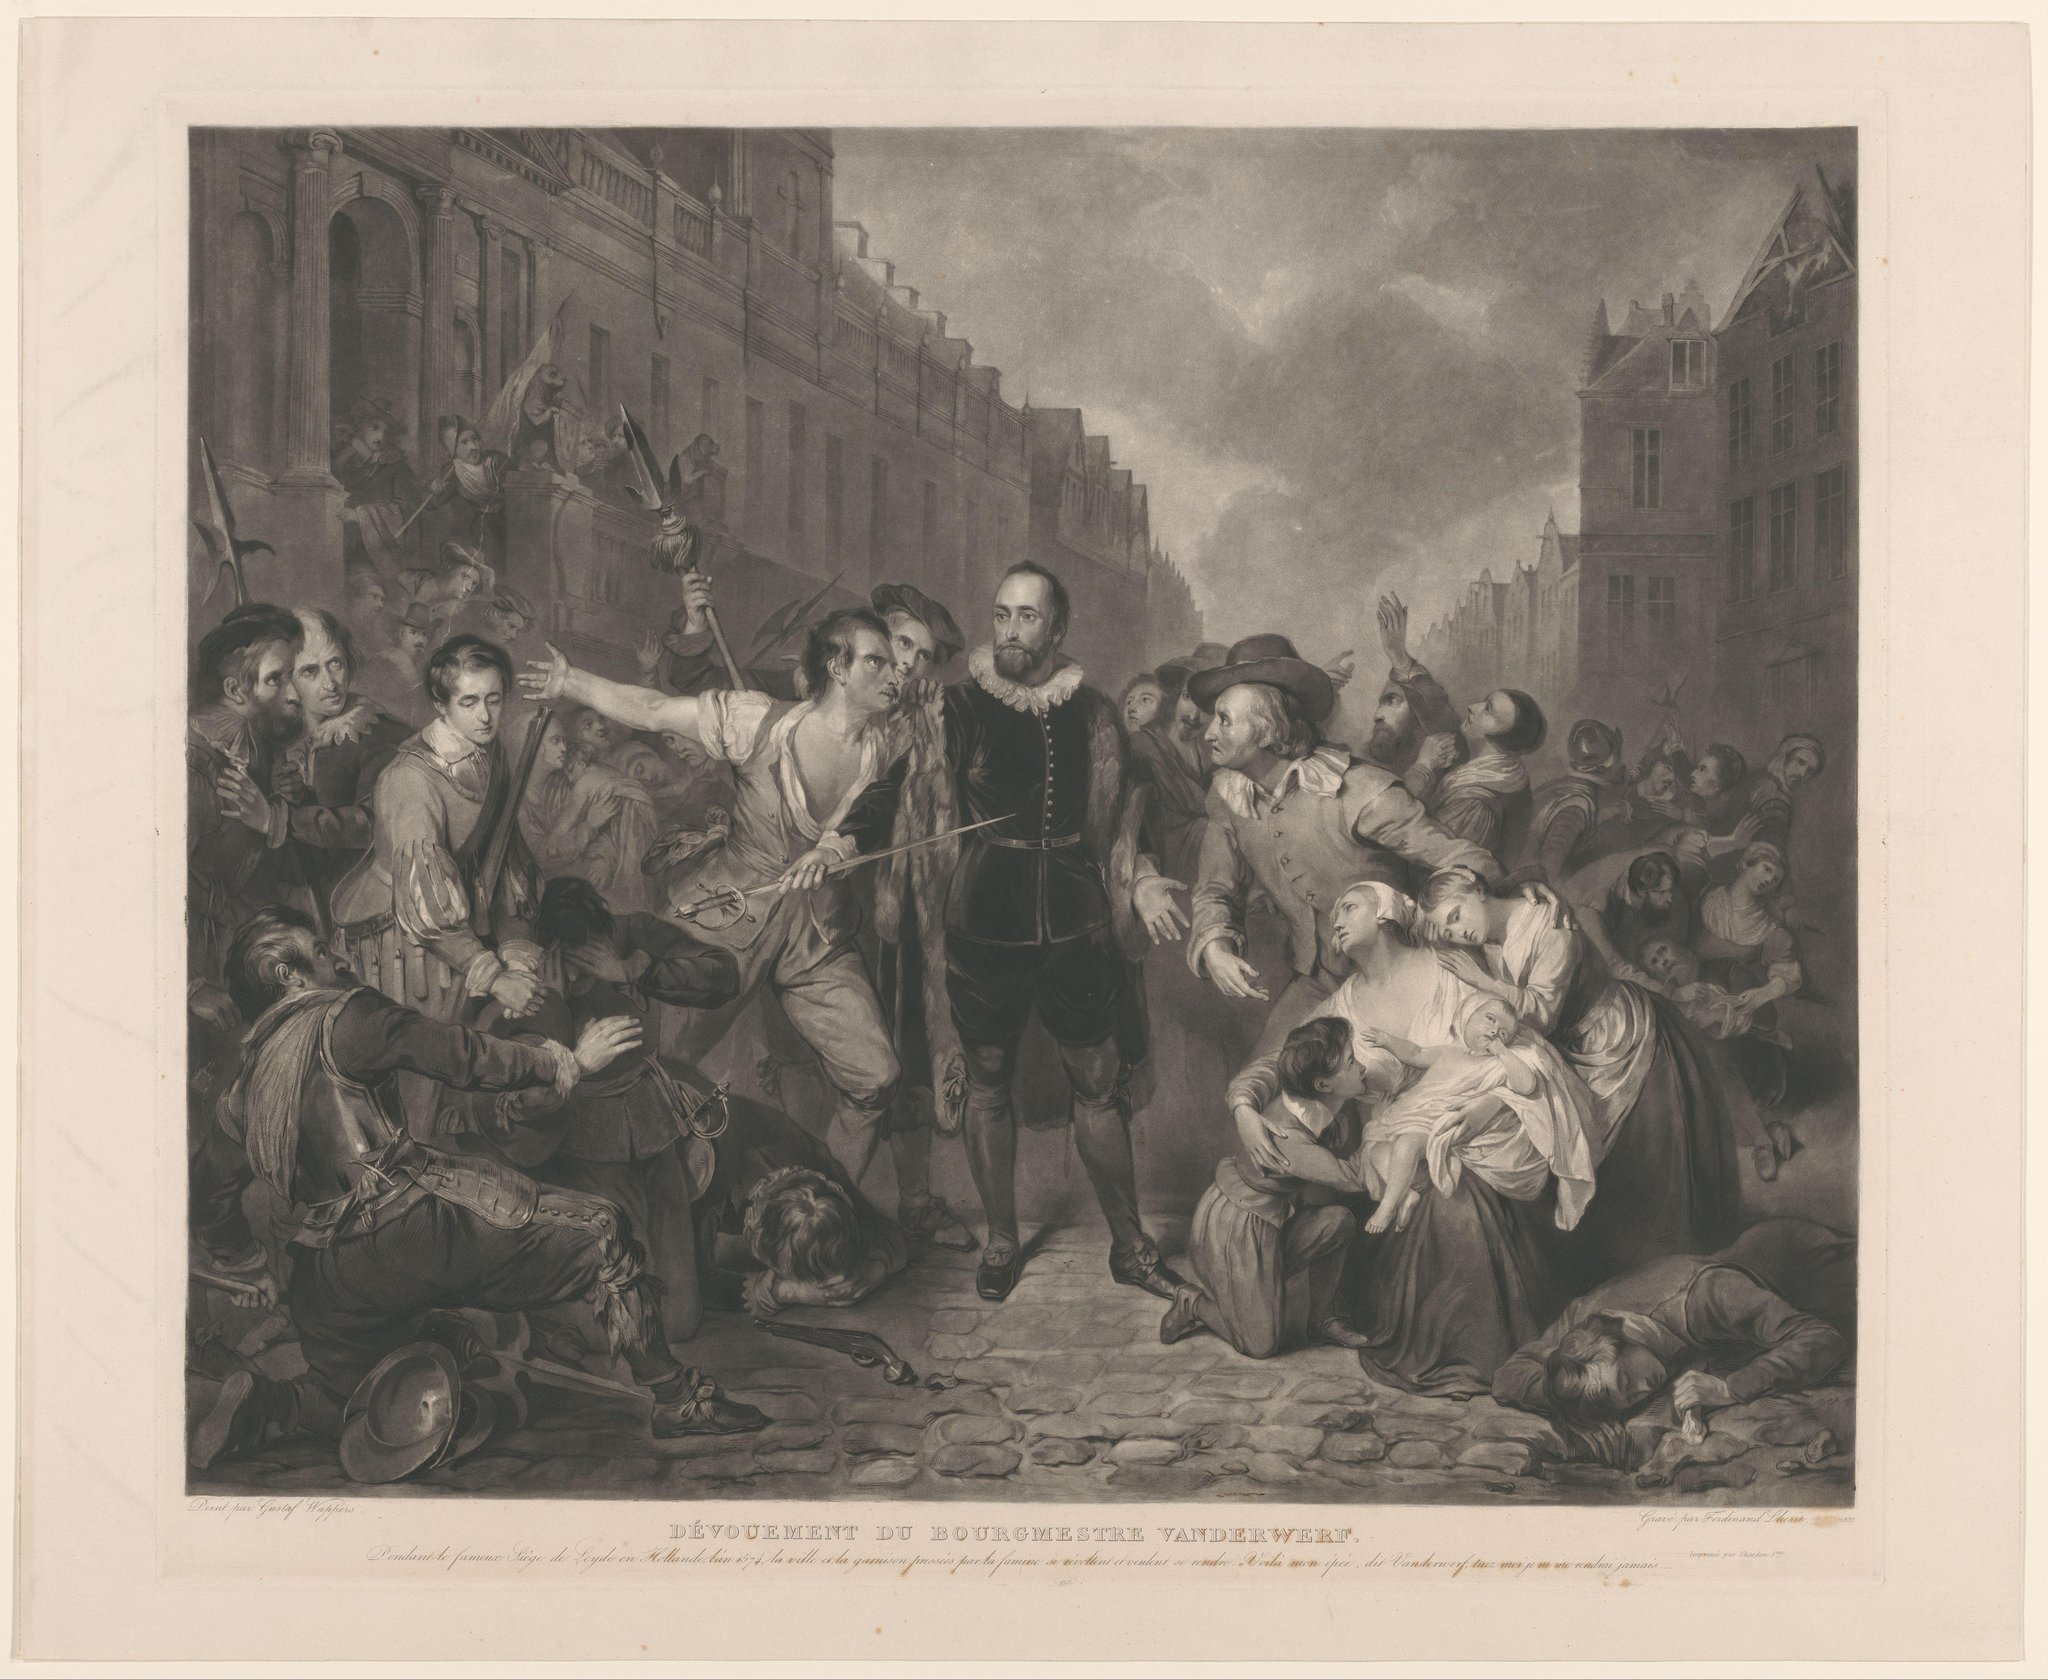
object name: print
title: Dévouement du Bourgmestre Vanderwerf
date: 1829-1848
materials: paper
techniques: aquatint, engraving, etching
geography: antwerp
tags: historical persons, leiden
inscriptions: collector's mark: Lugt 12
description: De zelfopoffering van burgemeester Pieter van der Werff tijdens het beleg van Leiden, 1574. Van der Werff staande op straat tussen wanhopige Leidenaren biedt hen zijn zwaard en lichaam aan.